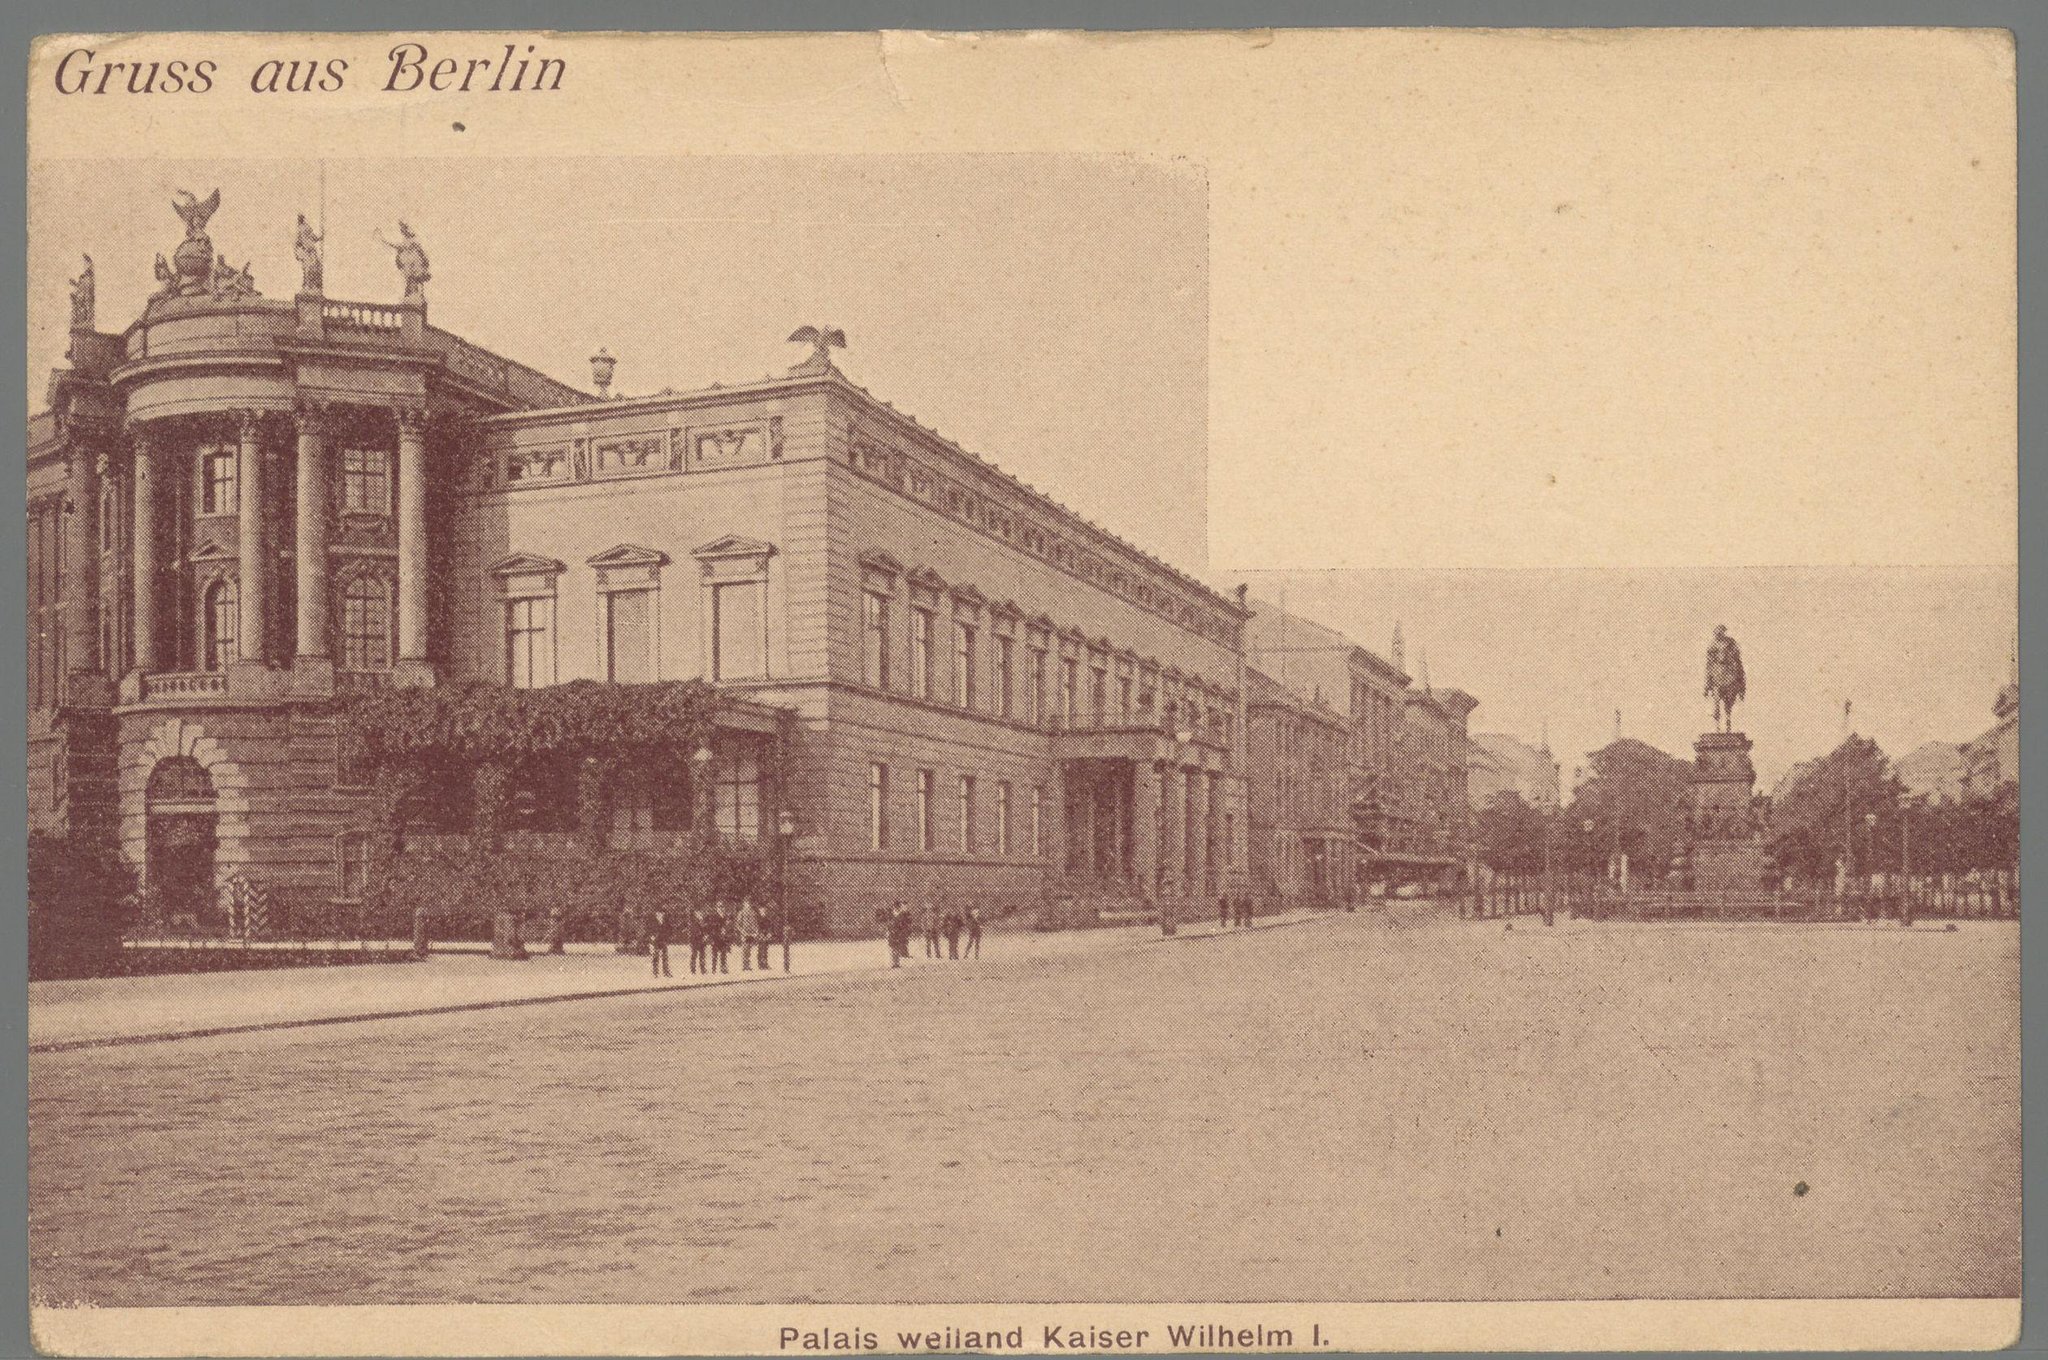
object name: ansichtkaart, prentbriefkaart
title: Gruss aus Berlin. Palais weiland Kaiser Wilhelm I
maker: Anonymous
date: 1890-1905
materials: cardboard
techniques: autotype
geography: berlin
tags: palace